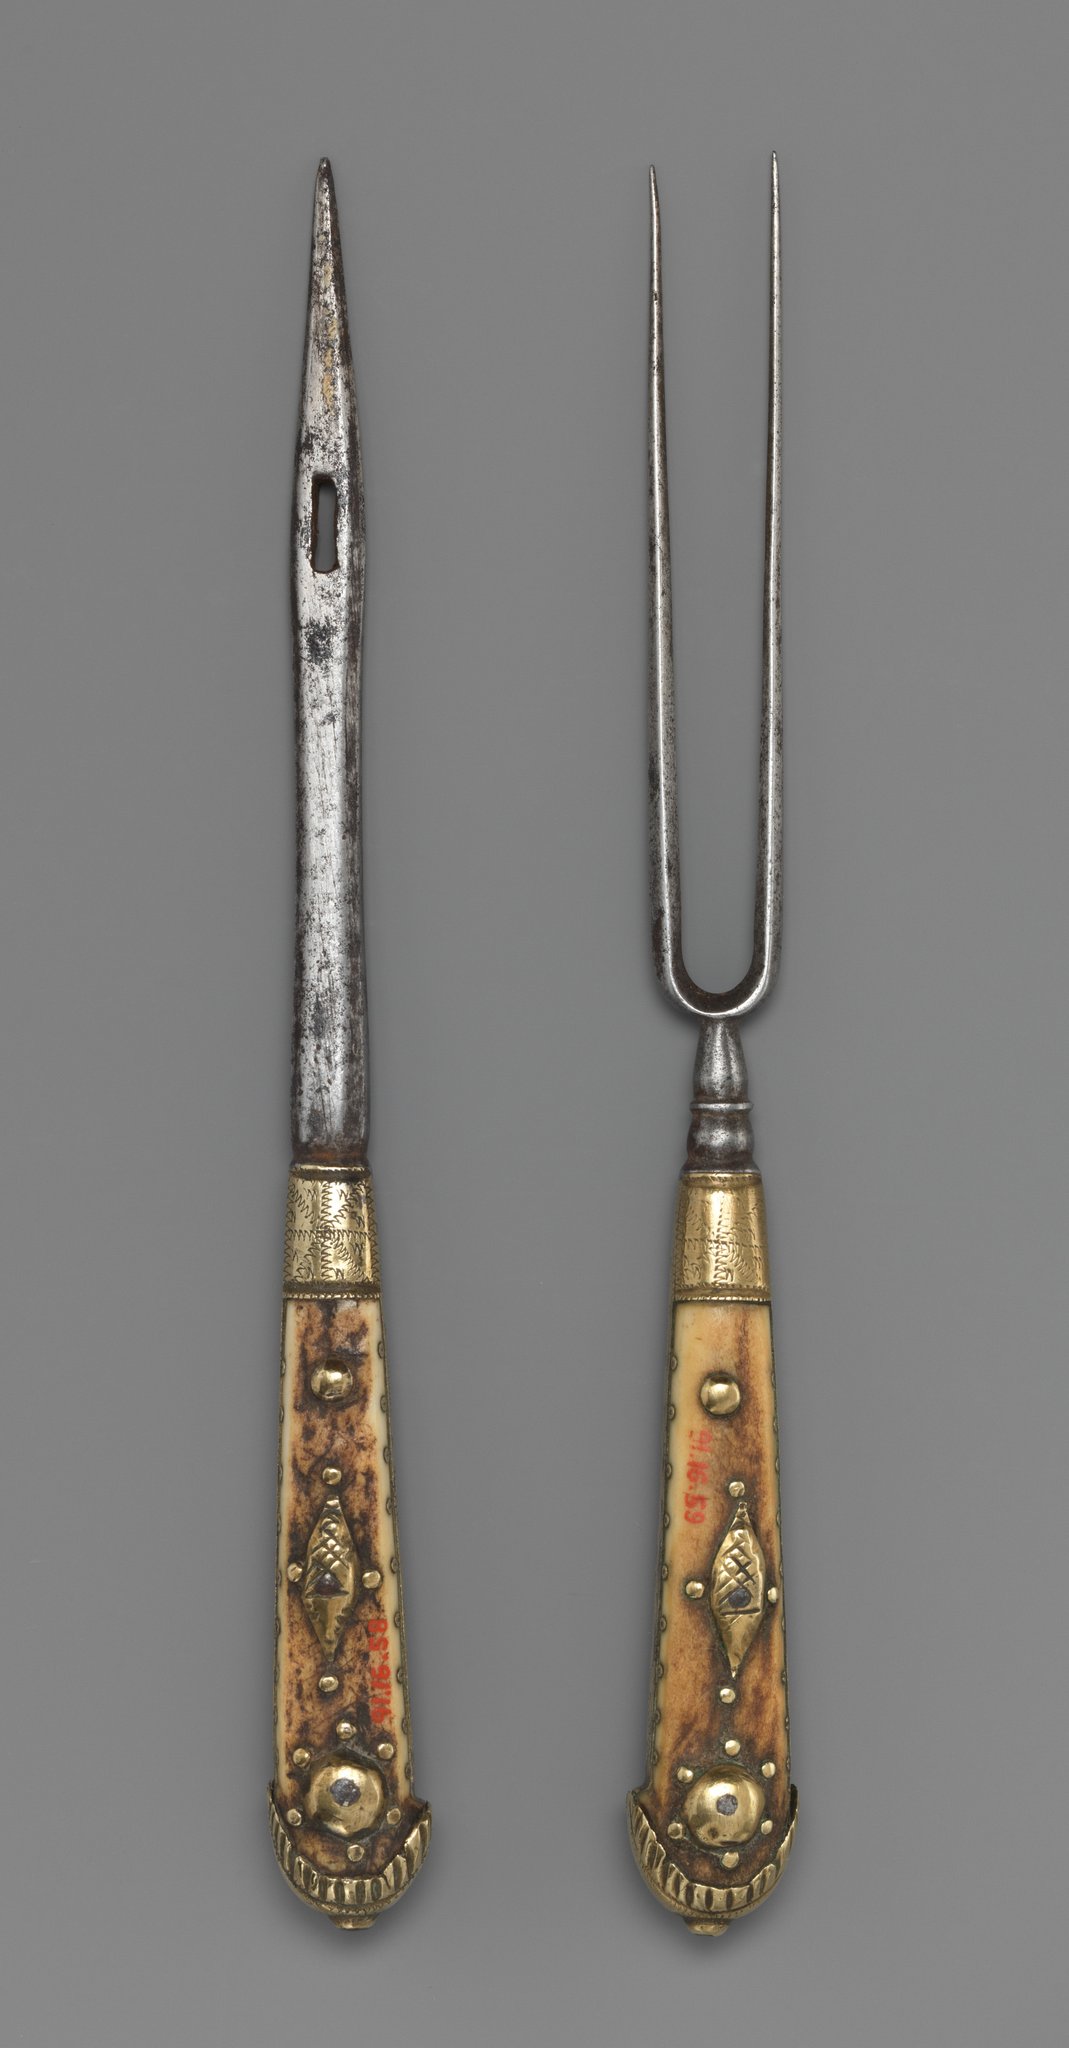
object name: fork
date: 1701-1800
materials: brass, steel